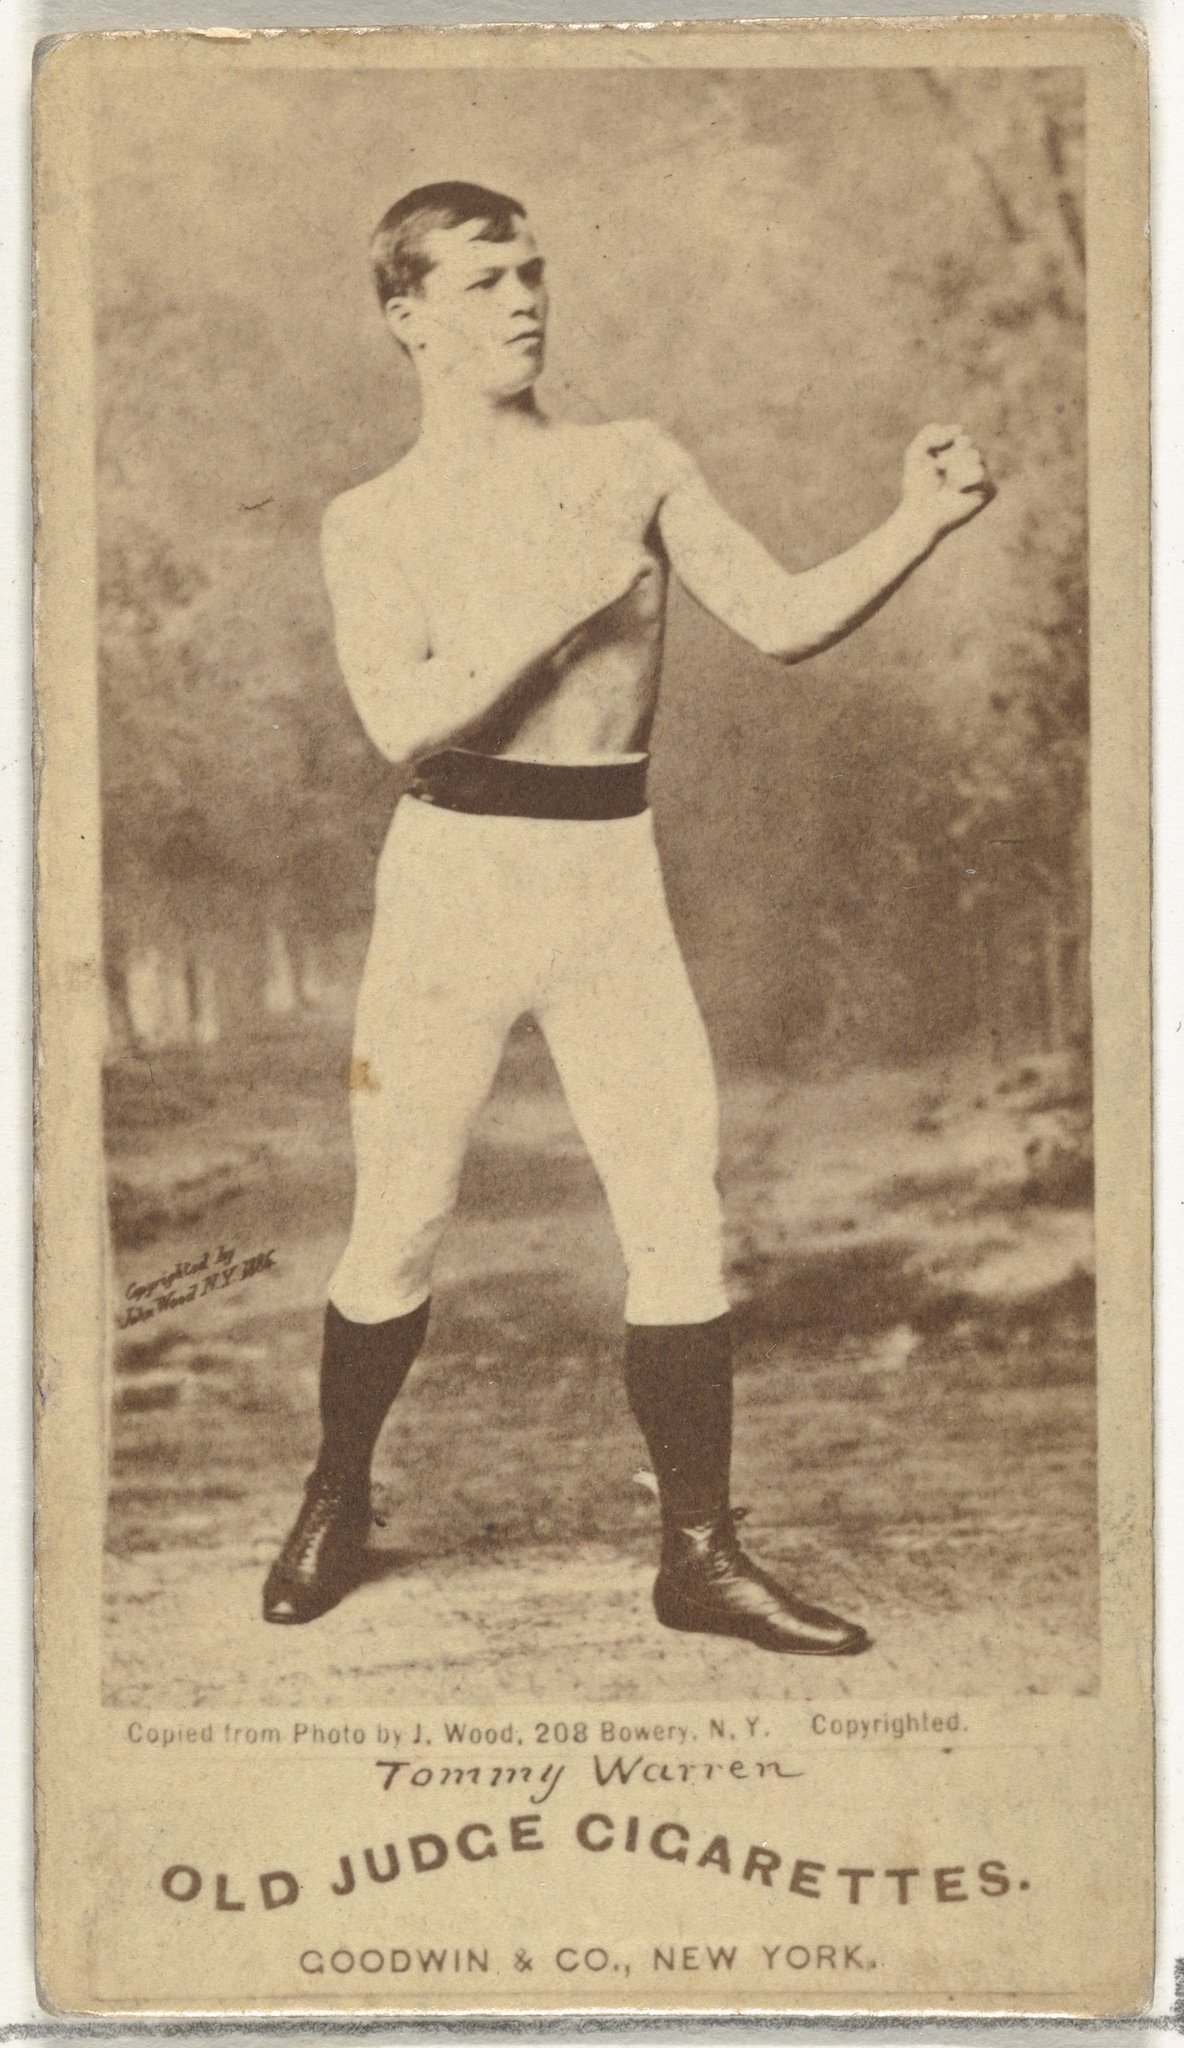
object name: photograph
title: Tommy Warren, from the Celebrities and Prizefighters series (N174) for Old Judge Cigarettes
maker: goodwin & company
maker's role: publisher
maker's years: 1850-1950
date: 1887-1888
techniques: albumen silver print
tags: men,portraits,baseball,athletes